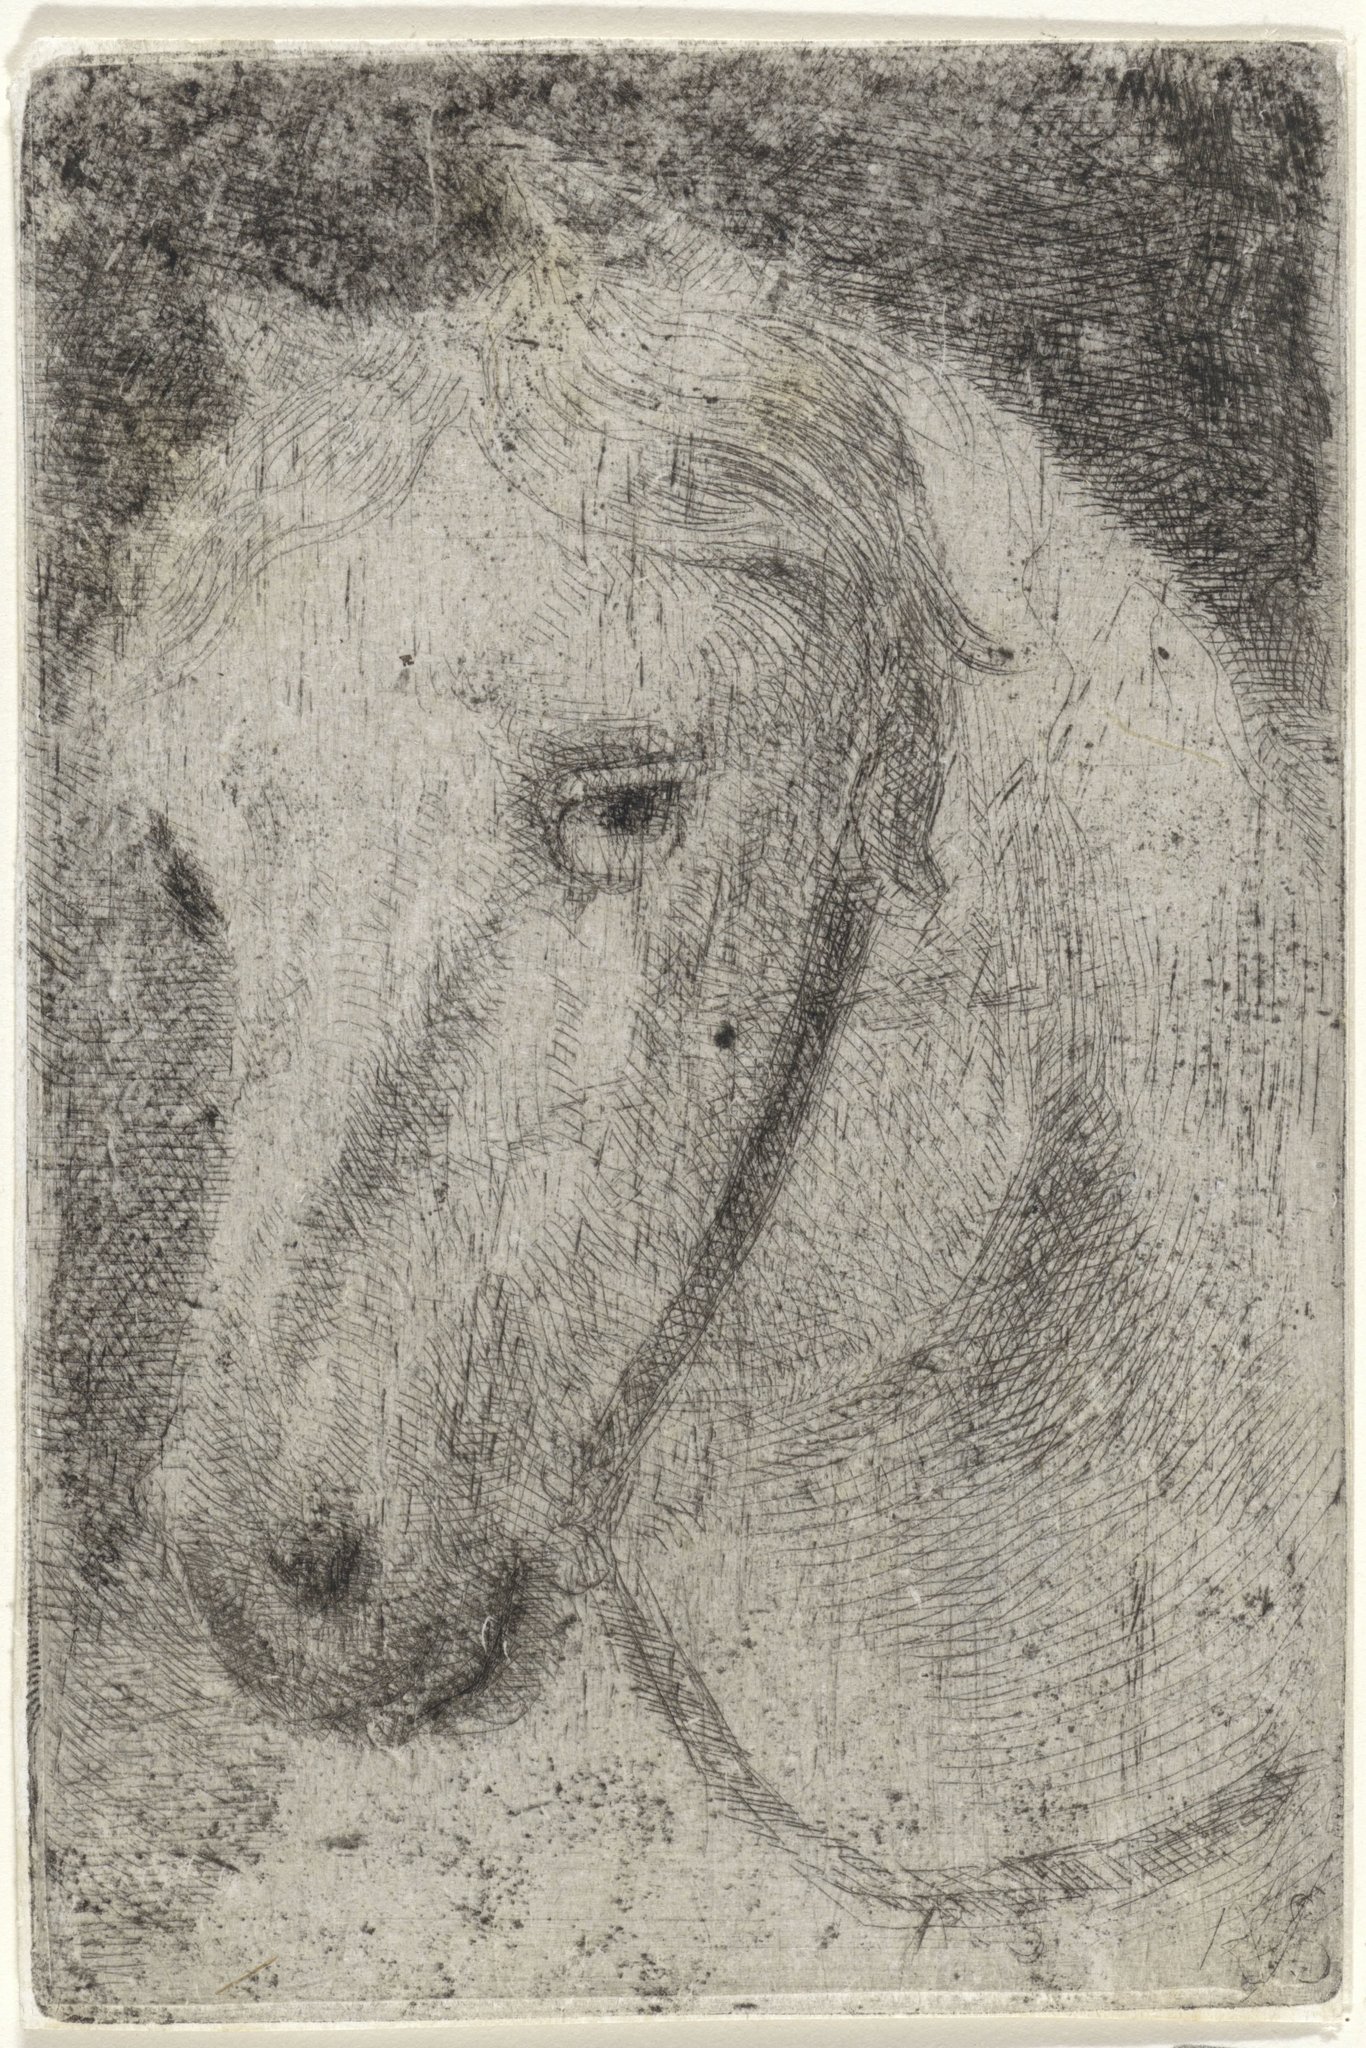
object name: print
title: Hoofd van een wit paard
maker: arnoud schaepkens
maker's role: print maker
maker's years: 1816-1904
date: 1831-1904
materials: paper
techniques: drypoint, etching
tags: horses and kindred animals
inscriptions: collector's mark: Lugt 2228